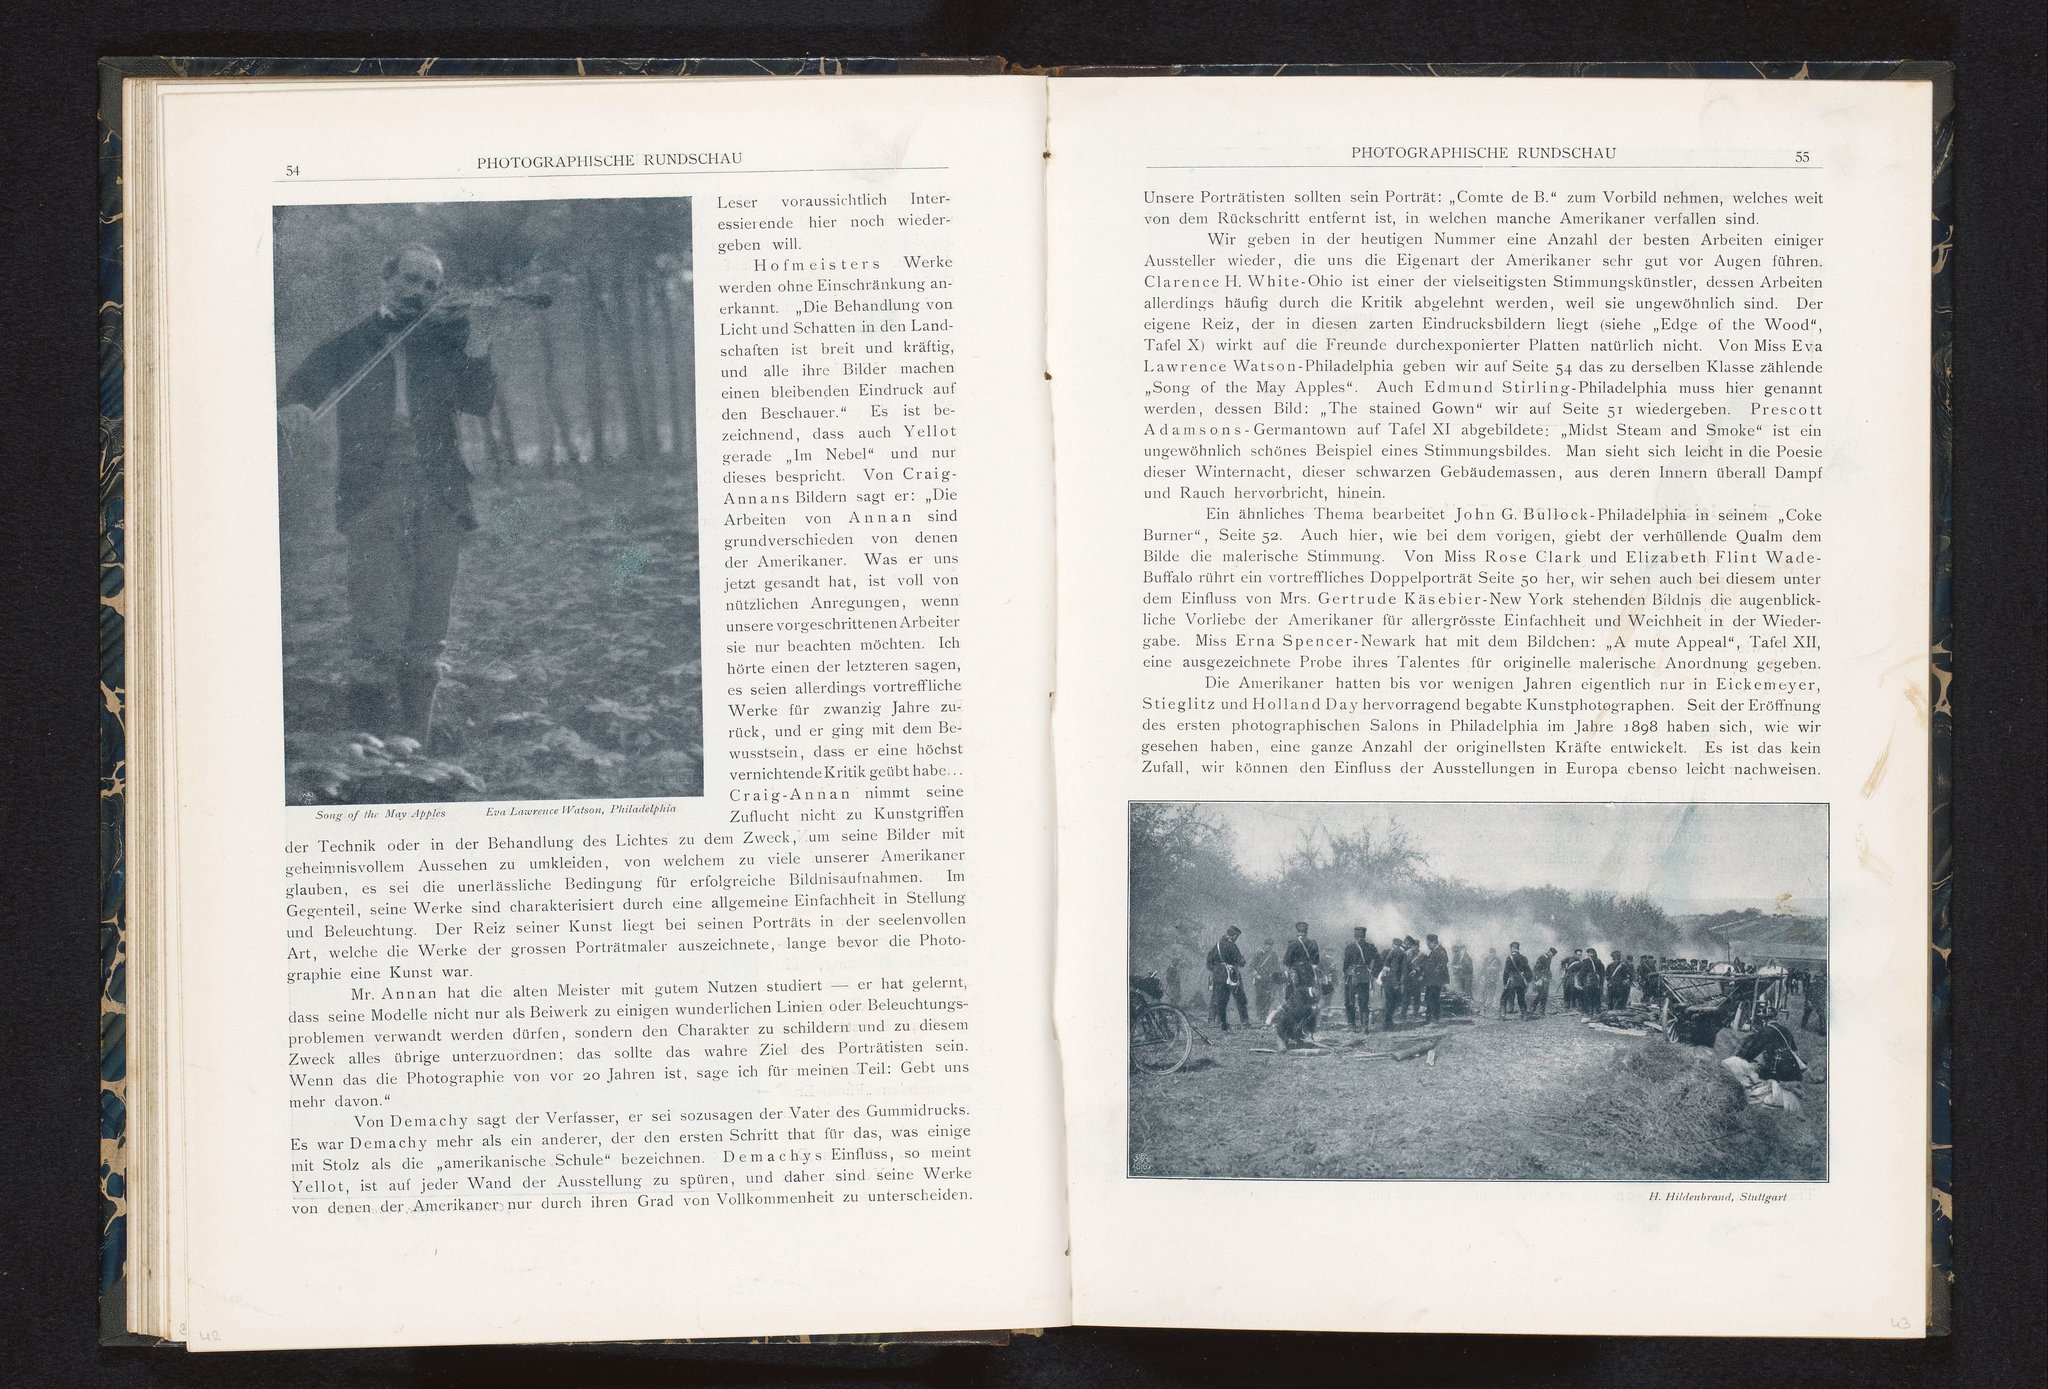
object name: photomechanical print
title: Song of the May Apples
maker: eva watson-schütze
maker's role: fotograaf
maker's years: 1867-1935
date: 1896-1901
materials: paper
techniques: autotype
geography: berlin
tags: violin, fiddle - cc - out of doors, historical persons not known by name